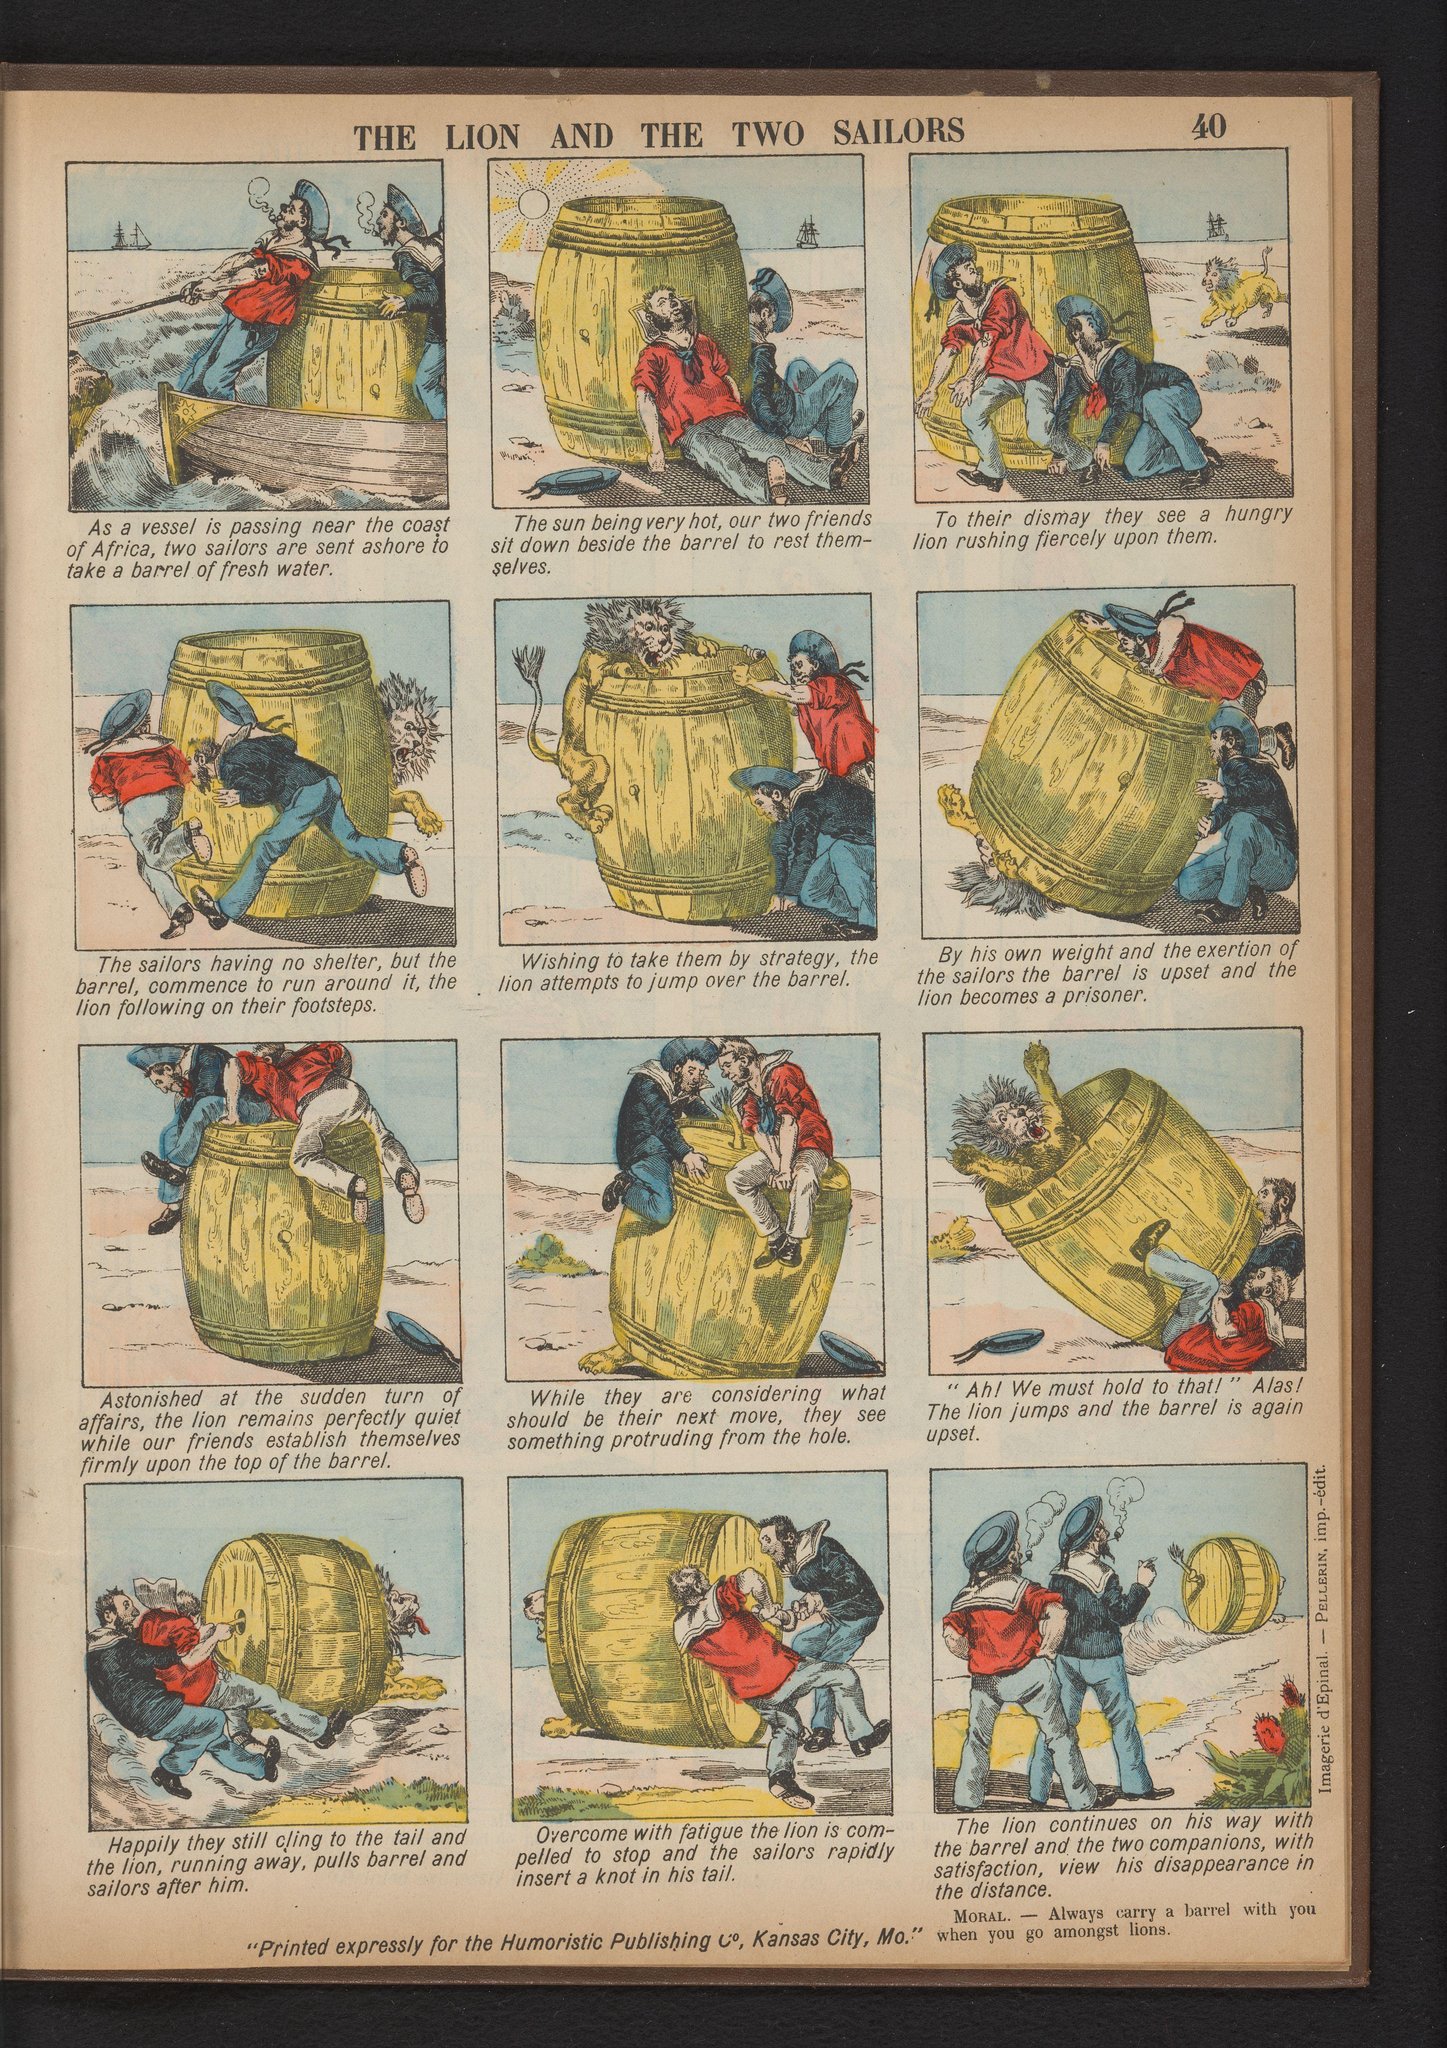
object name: popular print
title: Leeuw en twee matrozen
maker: Anonymous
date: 1893-1894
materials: paper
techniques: colour, letterpress printing, lithograph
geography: epinal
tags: wooden container: barrel, cask, bucket, literary characters and objects, beasts of prey, predatory animals: lion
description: Blad met zestien voorstellingen waarin twee matrozen hun leven redden van een hongerige leeuw dankzij een lege ton. Onder elke voorstelling een onderschrift in het Engels. Deze prent maakt deel uit van een album.